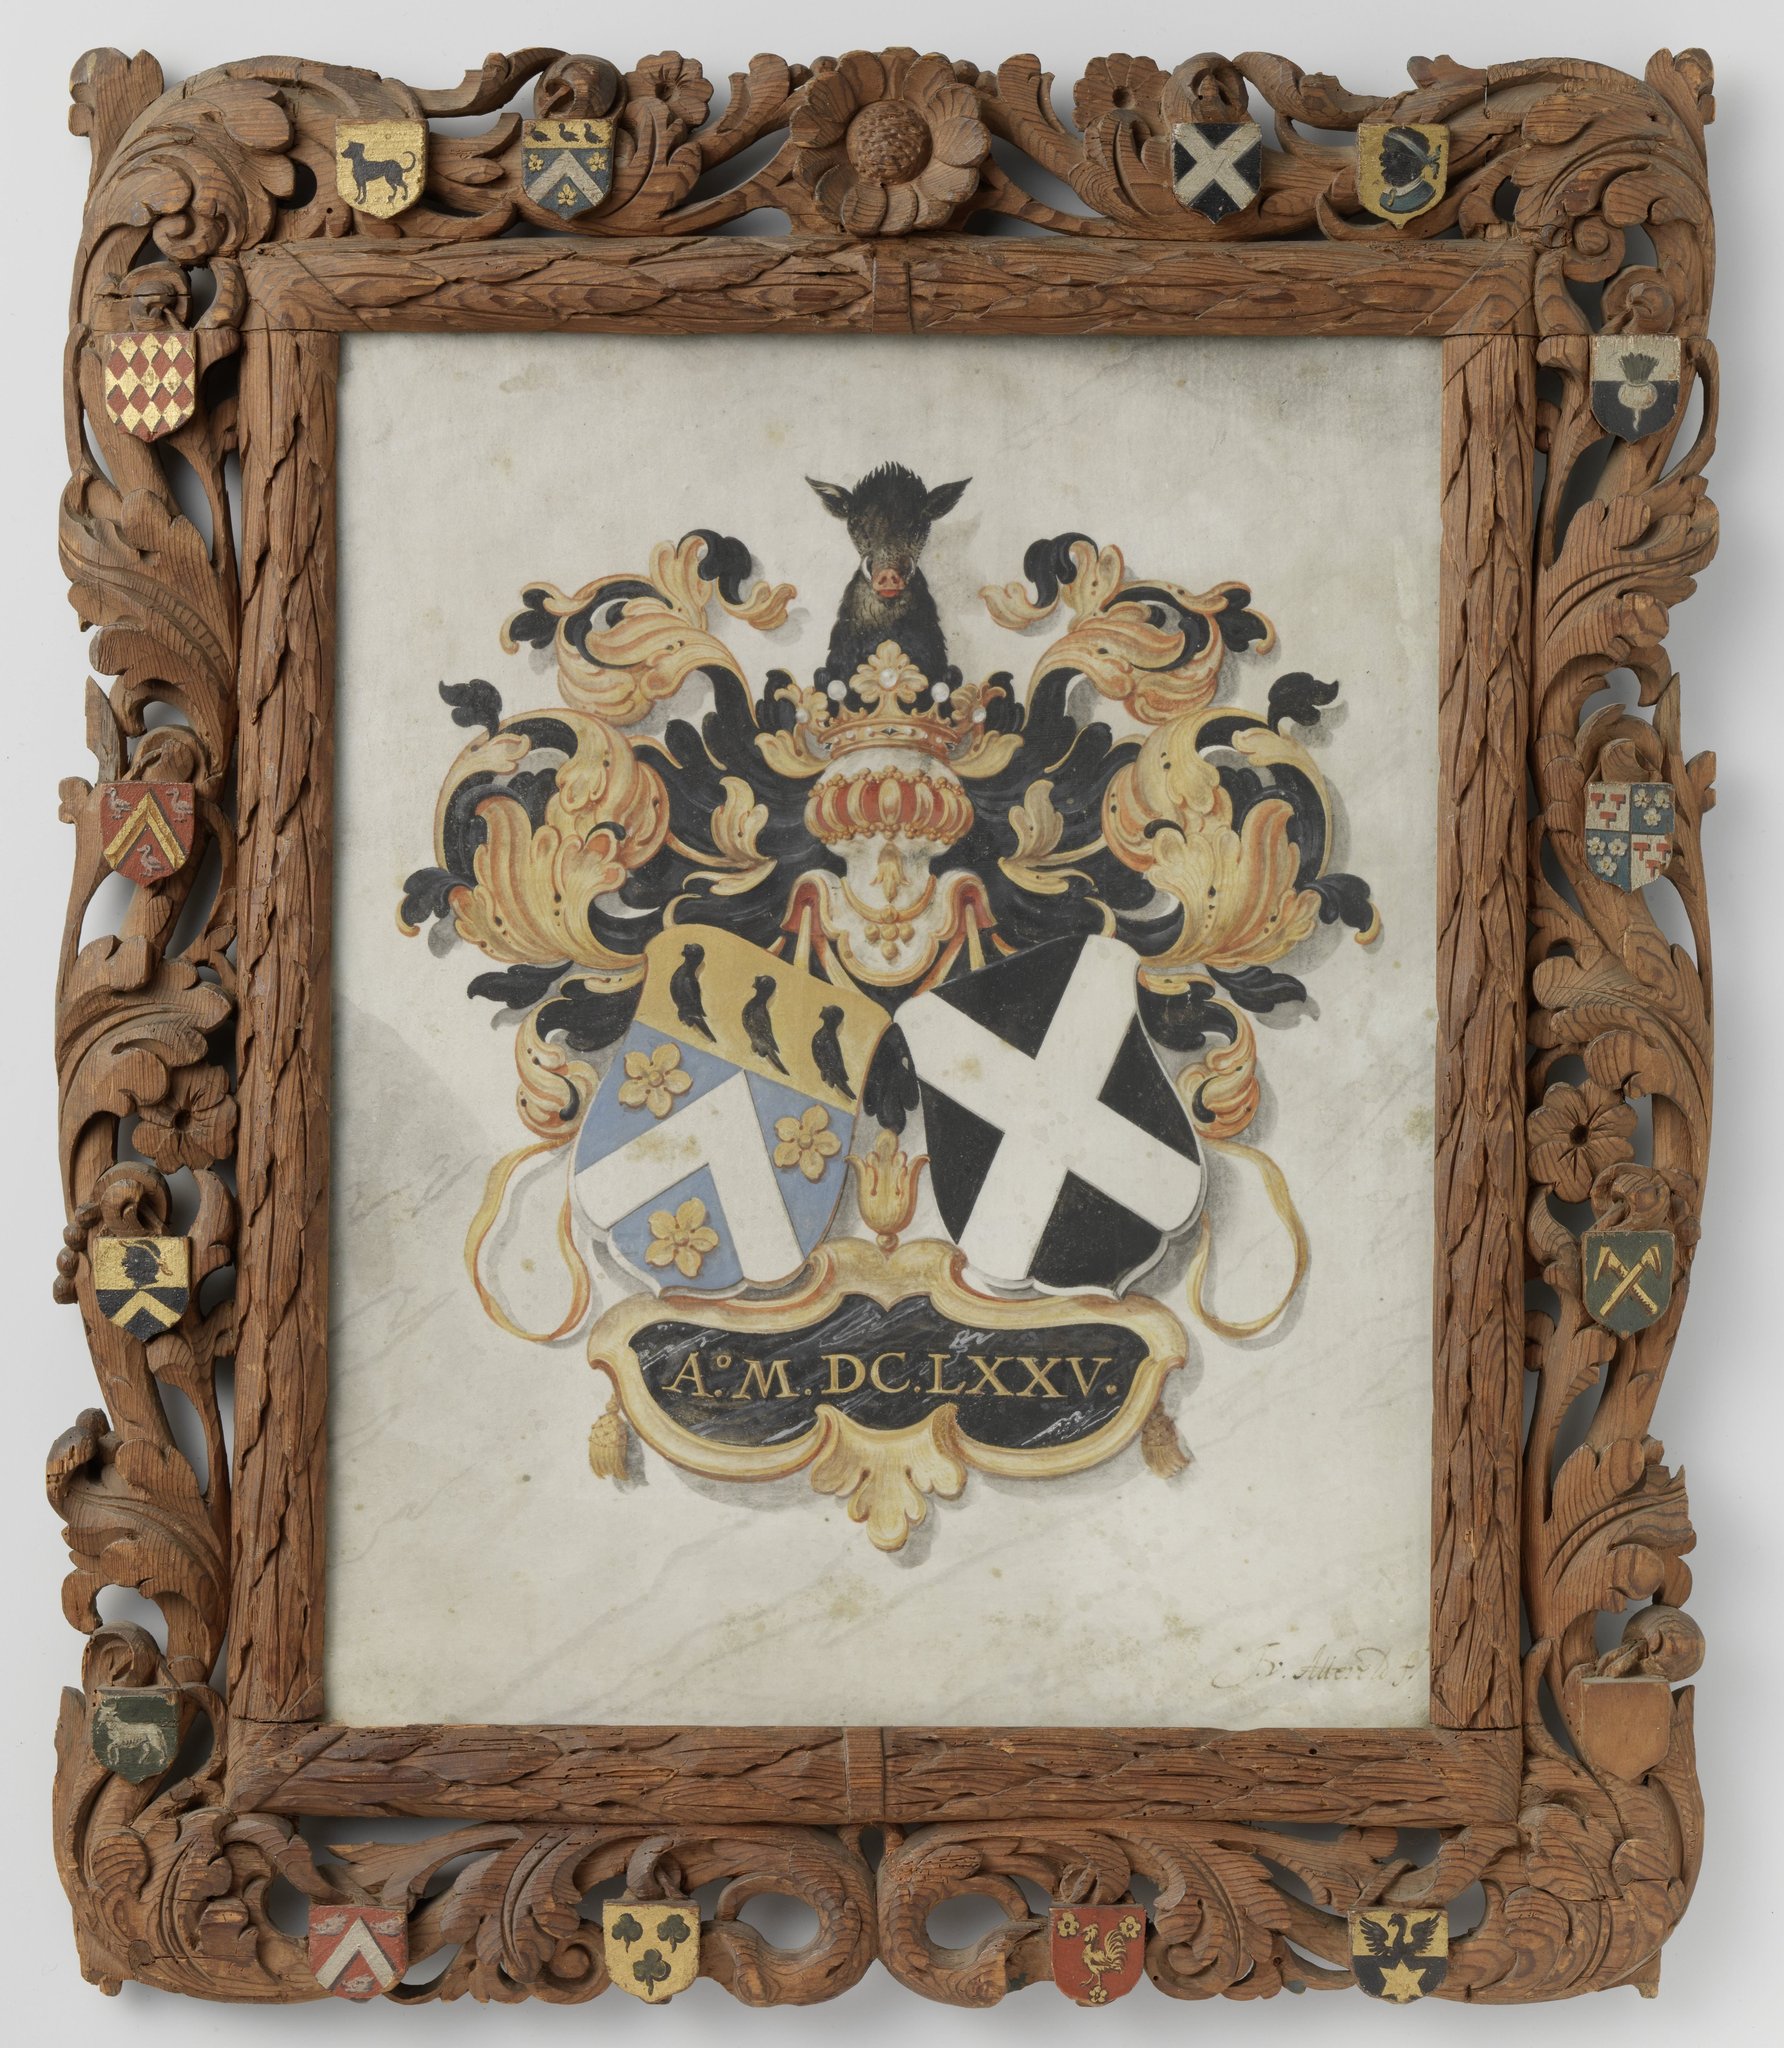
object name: drawing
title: De alliantiewapens van Jan Boudaen Courten en Anna Maria Hoeufft, overgrootouders van Jacob Verheye van Citters, in een gesneden houten lijst met de wapens van de zestien kwartieren van het echtpaar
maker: justus van attevelt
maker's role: draughtsman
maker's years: 1621-1692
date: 1675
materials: parchment, watercolor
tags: armorial bearing, heraldry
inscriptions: signature and date: ‘J. v. Atteveld ft / Aº M.DC.LXXV.’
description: De alliantiewapens van Jan Boudaen Courten (1635-1716) en Anna Maria Hoeufft (1646-1715), overgrootouders van Jacob Verheye van Citters, in een gesneden houten lijst met de wapens van de zestien kwartieren van het echtpaar. Links van boven naar beneden: 1: Boudaen, 3: Courten 2: ?, 4: Cassier, 5: Fourmenois, 7: Del Prado (of Del Prato), 6: Hureau, 8: Pellicorne. Rechts van boven naar beneden: 1: Hoeufft, 3: Luls, 2: van Wessem, 4: van Hoven, 5: Deutz, 7: Coymans, 6: Schroeff, 8: de Pickere. Onderdeel van een reeks wapens behorend bij de schenking Jonkheer J. de Witte van Citters, Den Haag, 1876. Onderdeel van de collectie heraldische objecten.